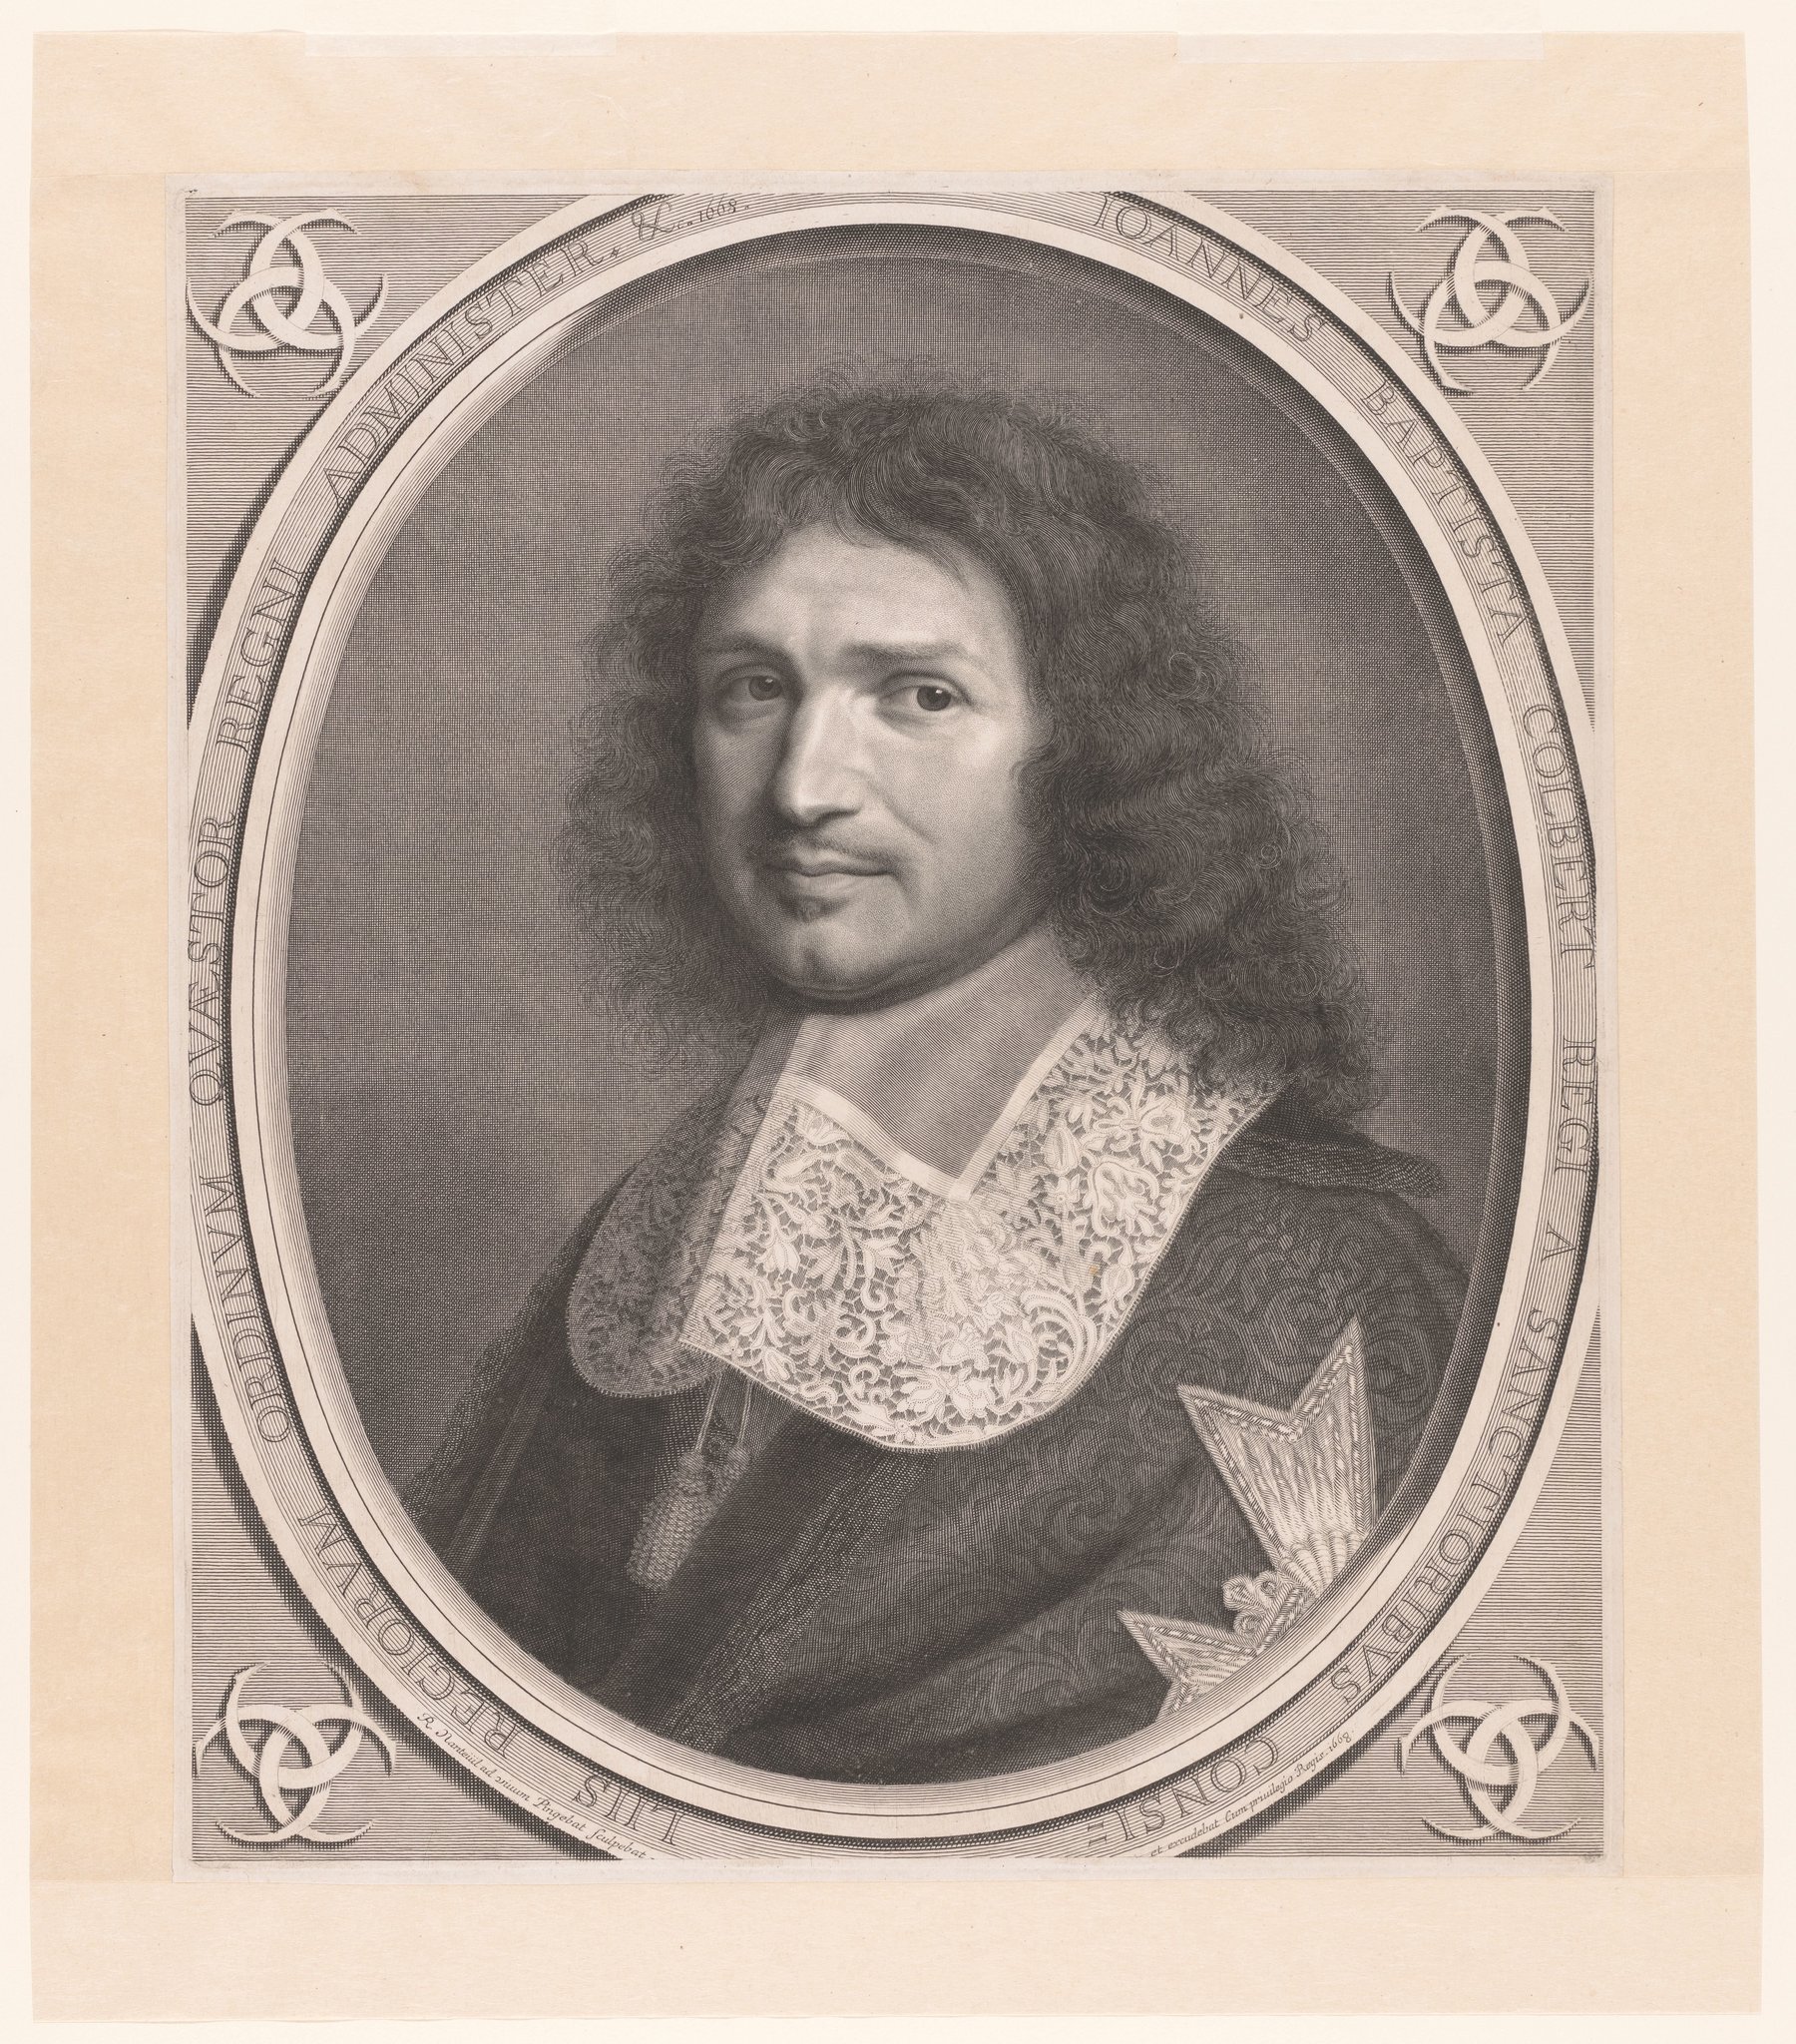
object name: print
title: Portret van Jean-Baptiste Colbert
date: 1668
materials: paper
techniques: engraving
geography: france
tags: paris, politician, jean-baptiste colbert, minister ~ government, historical persons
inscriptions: collector's mark: Lugt 240